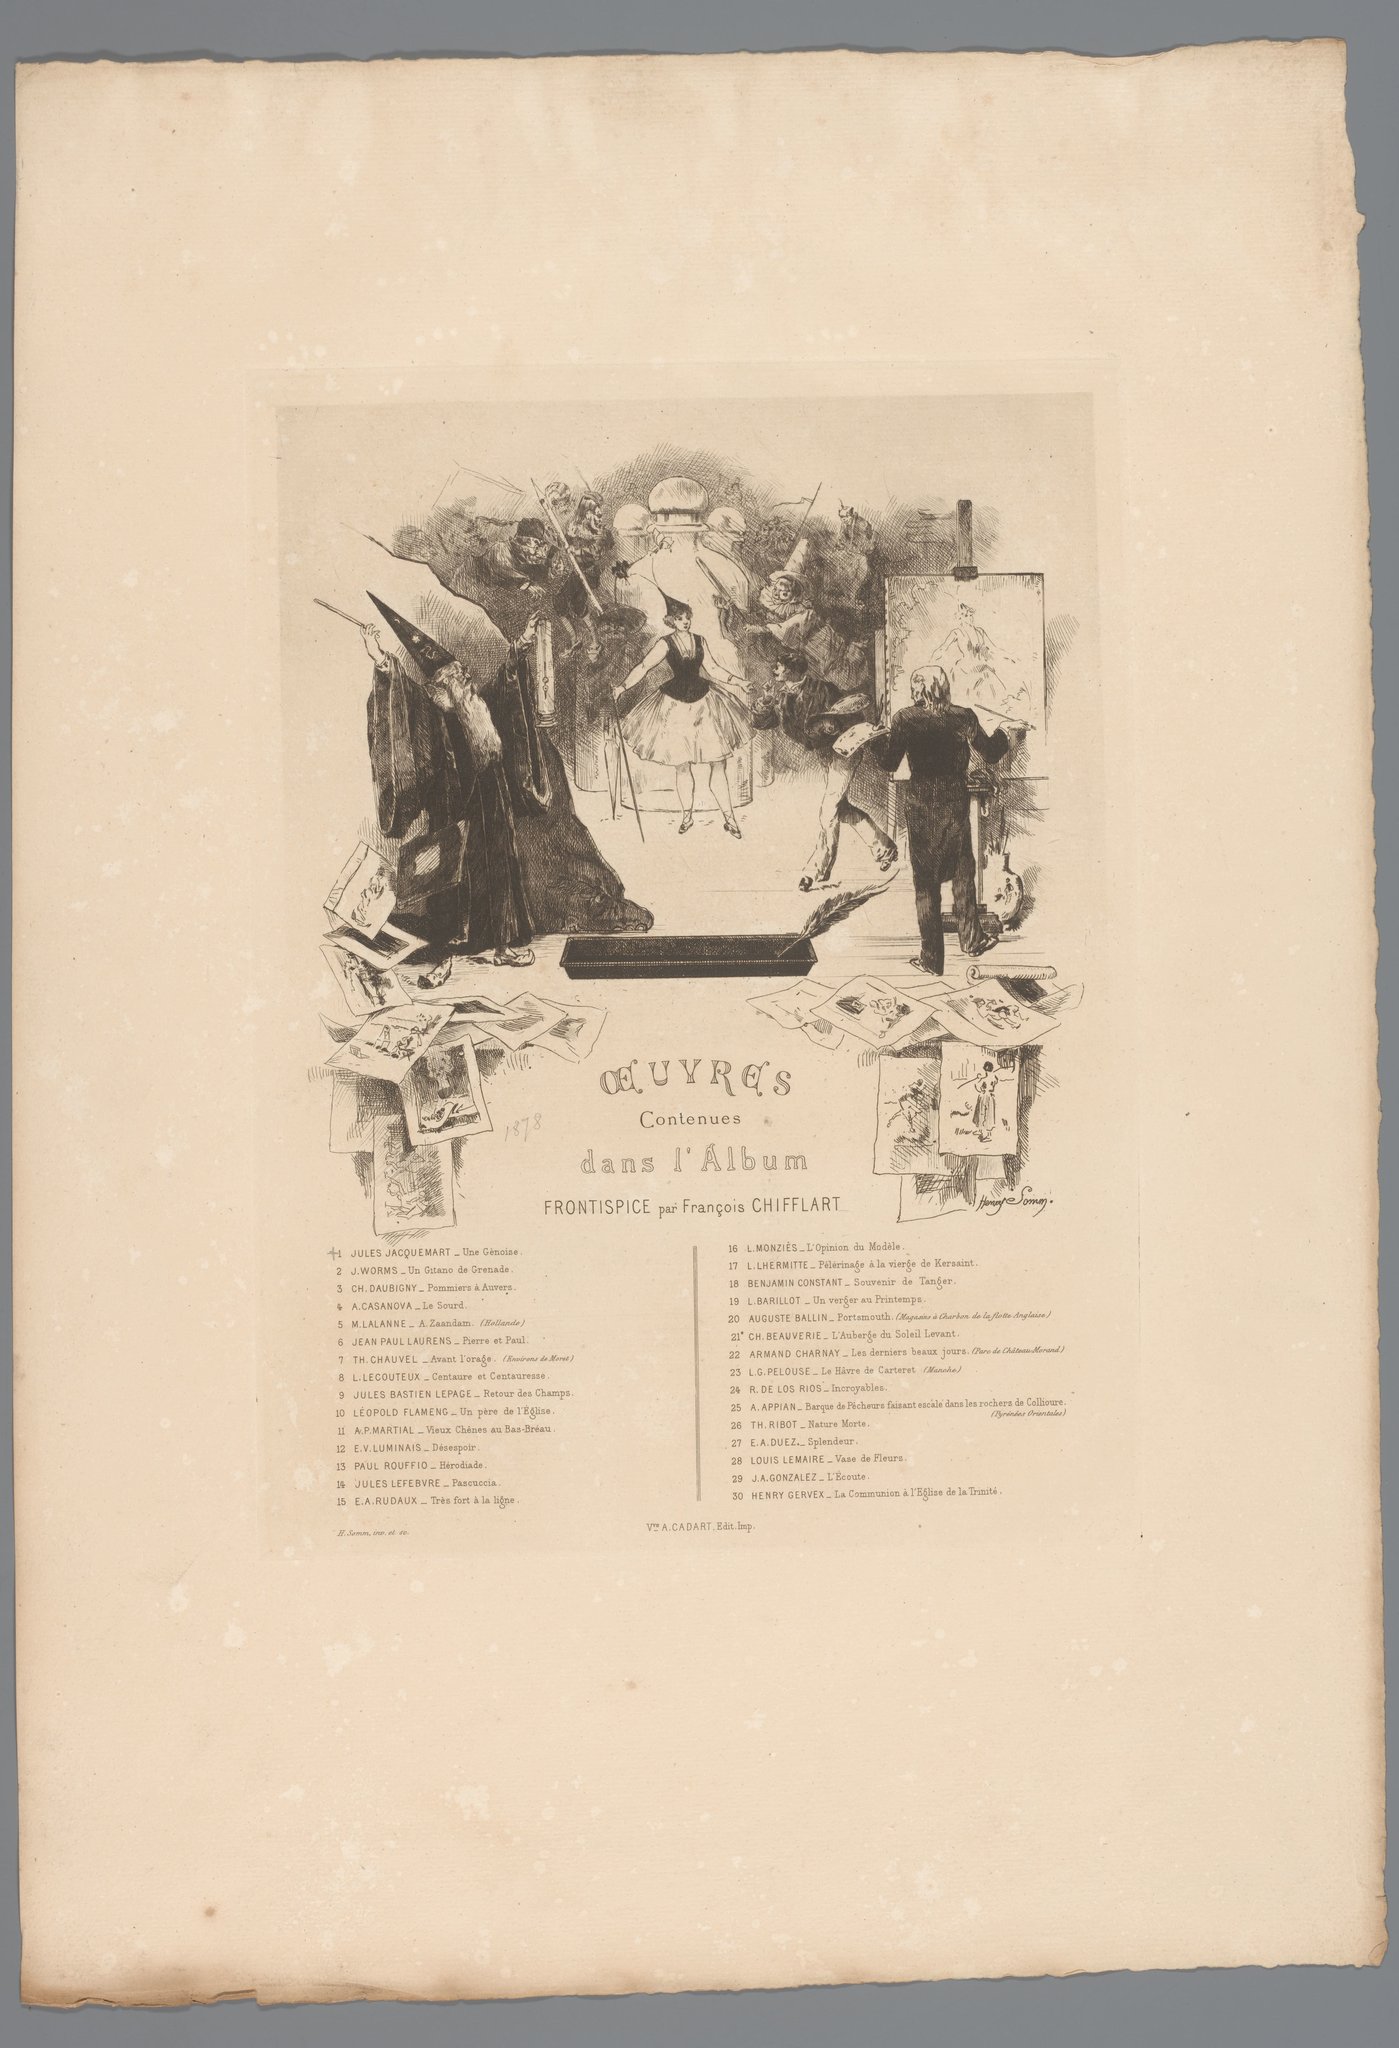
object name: print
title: Oeuvres Contenues dans l'Album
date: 1878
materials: paper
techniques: drypoint, etching, intaglio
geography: paris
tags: sorcerer, magician, wizard, warlock, painter at work, in his studio, female dancer, production of printed matter, book-production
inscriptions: collector's mark: ‘AFE v S’, watermark, collector's mark: Lugt 2760, collector's mark: Lugt 2228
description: Tovenaar, ballerina en schilders omringd door prenten en materialen om prenten mee te maken.